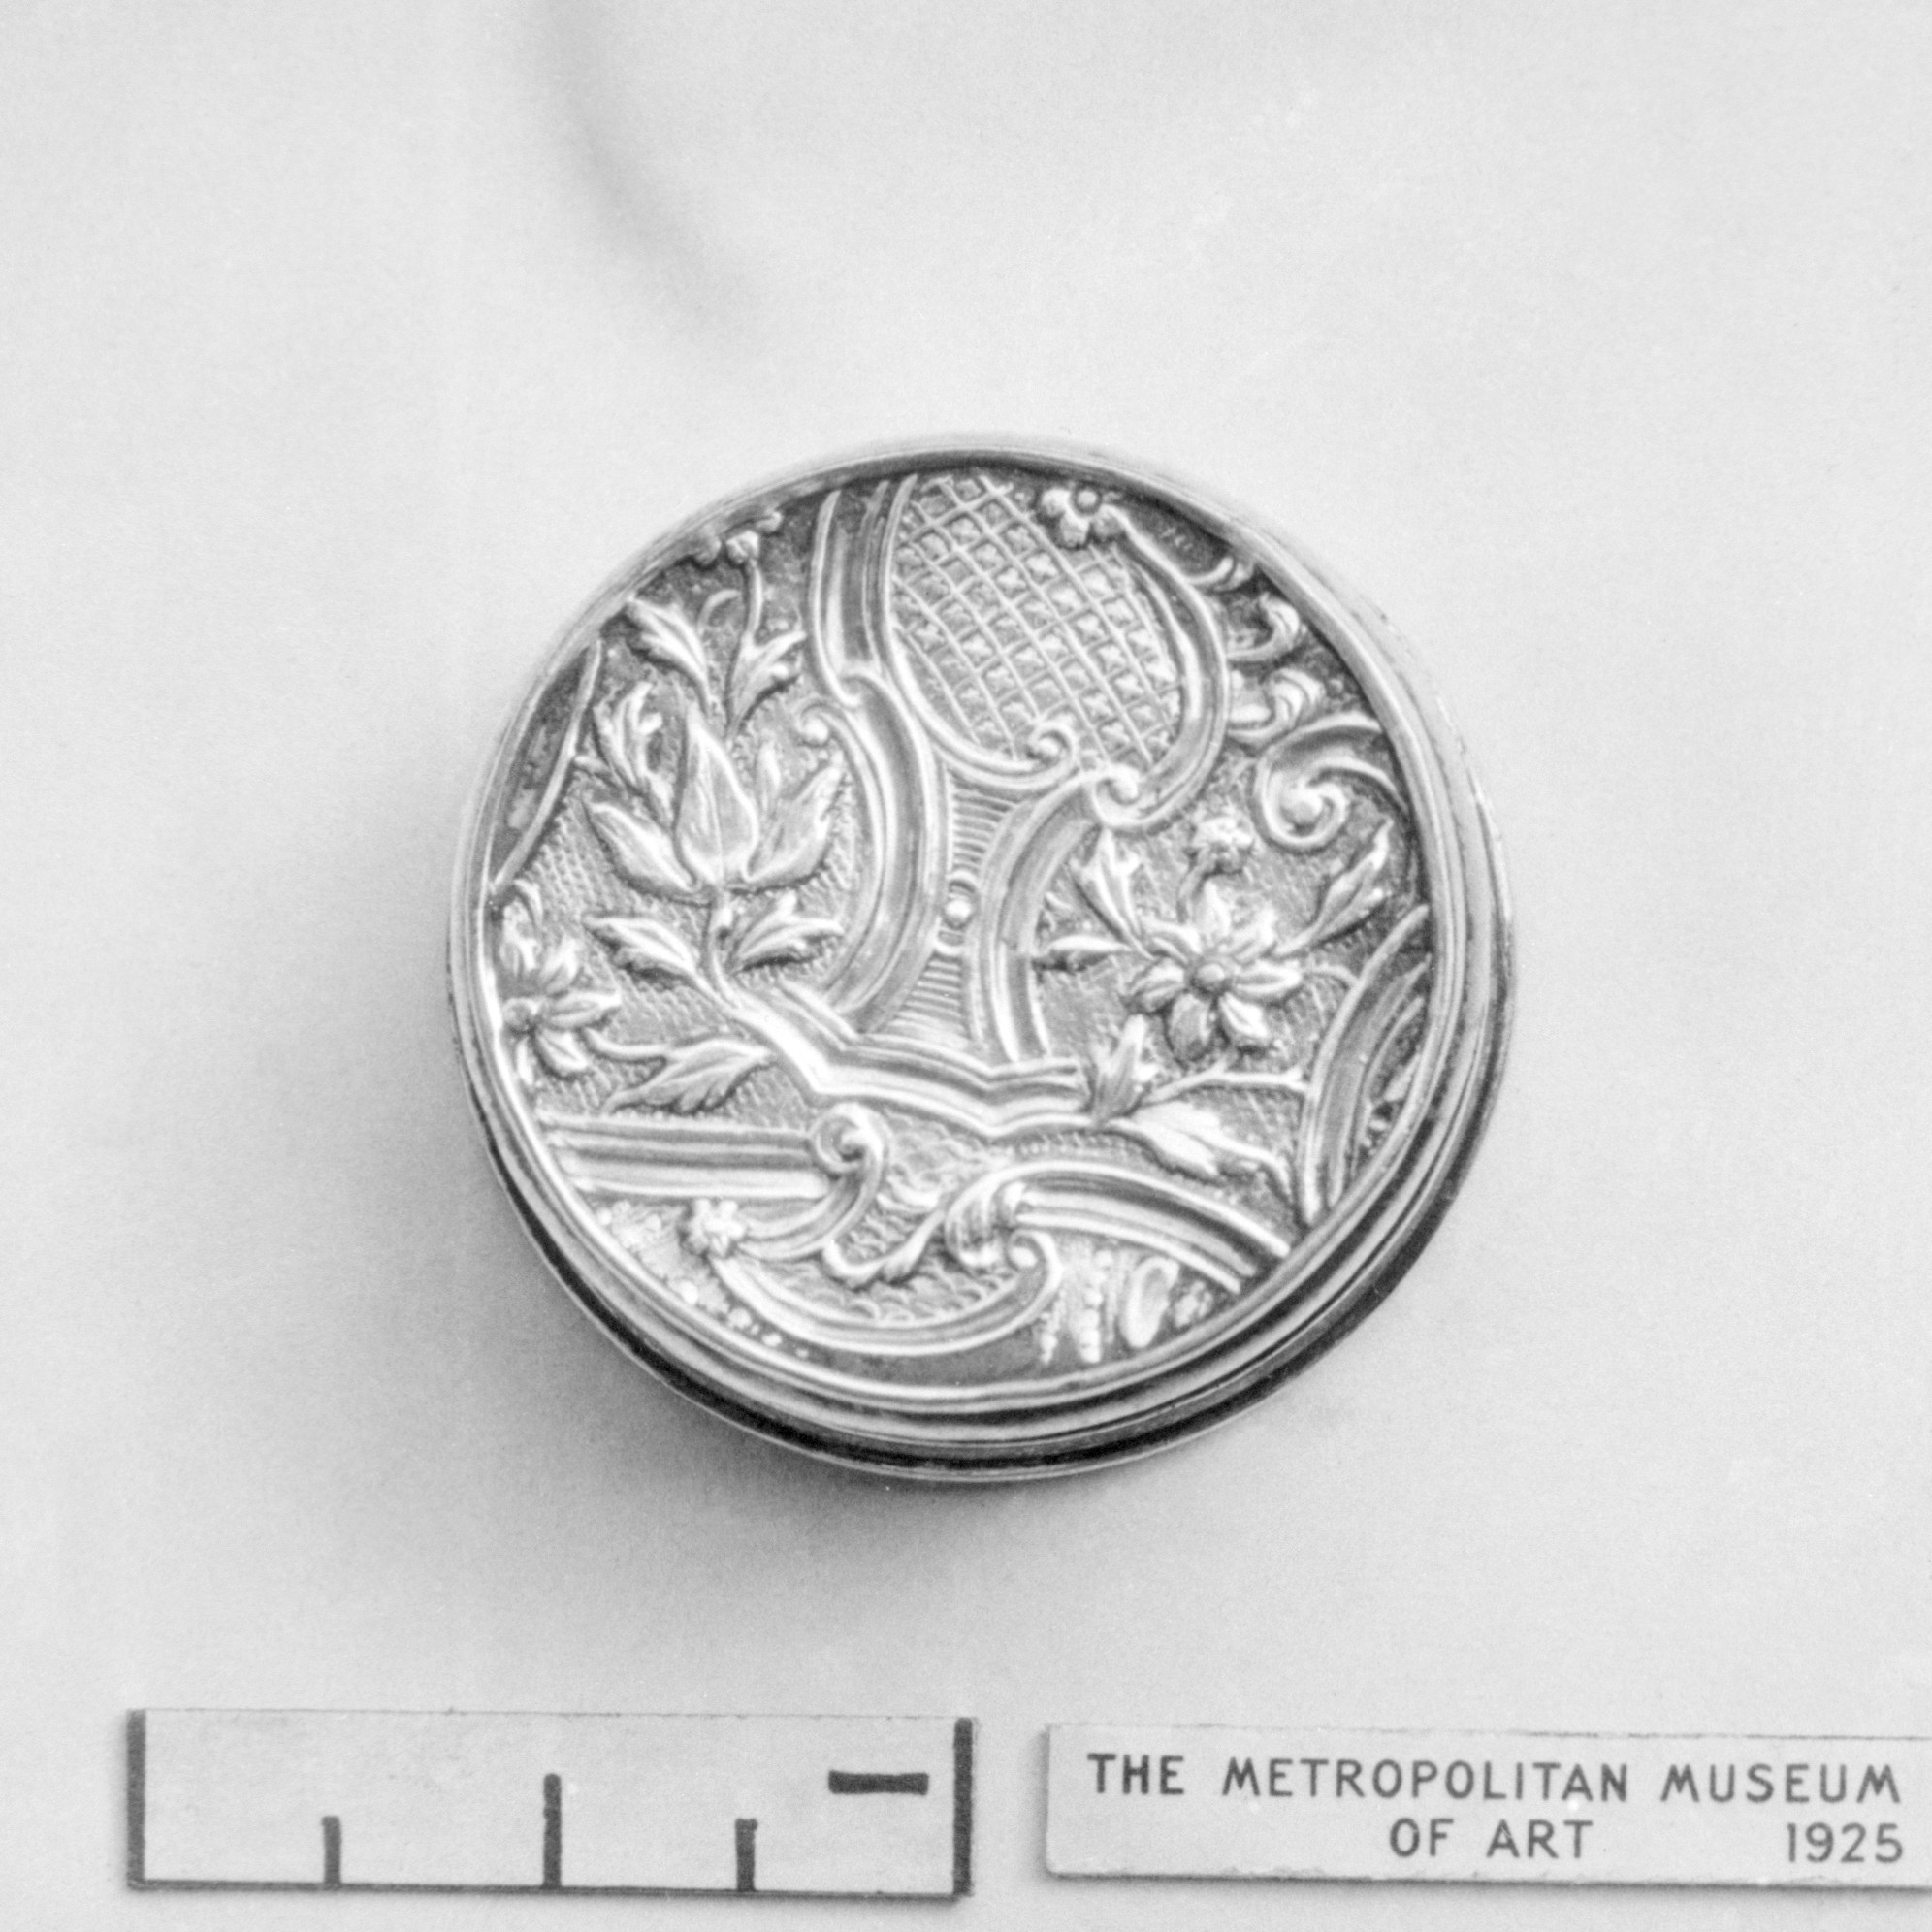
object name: patch box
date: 1748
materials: metal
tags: flowers,leaves